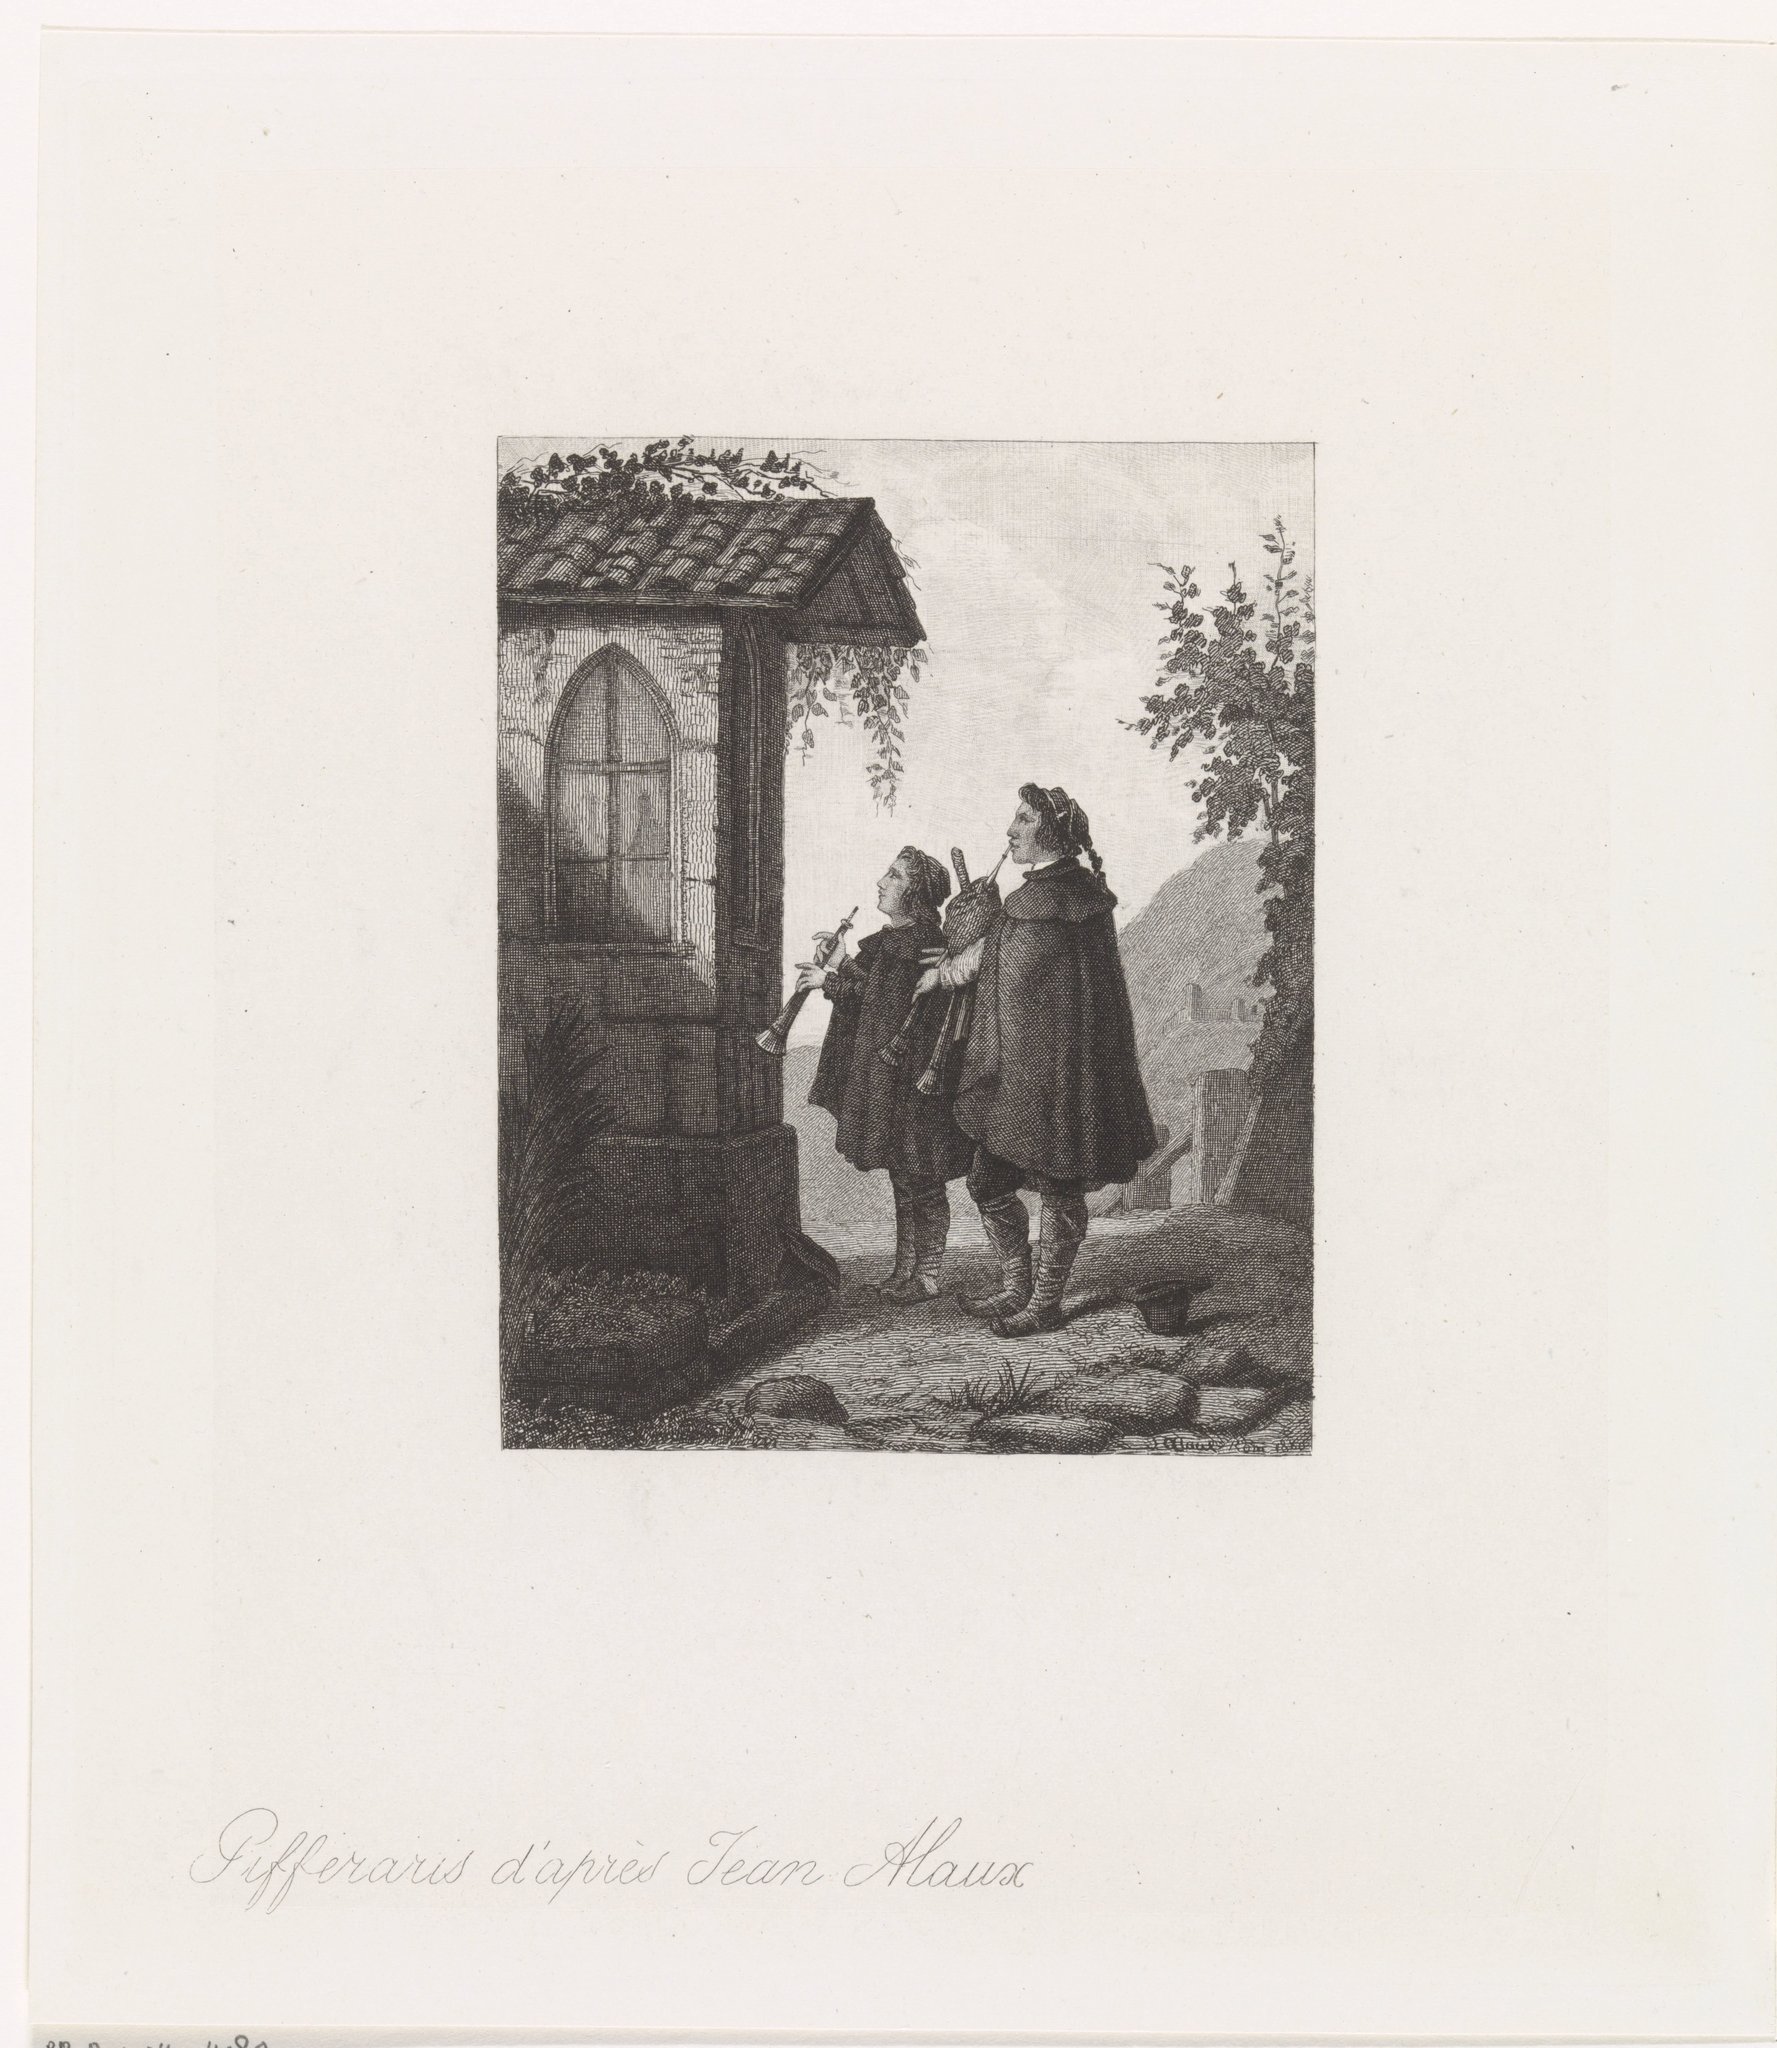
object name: print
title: Pifferaris d'après Jean Alaux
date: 1885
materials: paper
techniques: engraving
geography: amsterdam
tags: bagpipe, musette - cc - out of doors, flute, aulos, tibia - cc - out of doors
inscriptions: collector's mark: Lugt 2228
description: Prent ook gebruikt als illustratie in: L'album T. douze eaux-fortes d'après des dessins originaux et inédits de Jean Alaux, Léon Cogniet, Coutan, Henriquel Dupont, Ingres, Léopold Robert et Etna Michalon avec texte explicatif et biographique enrichi de lettres inédites. Amsterdam en Den Haag: 1885.